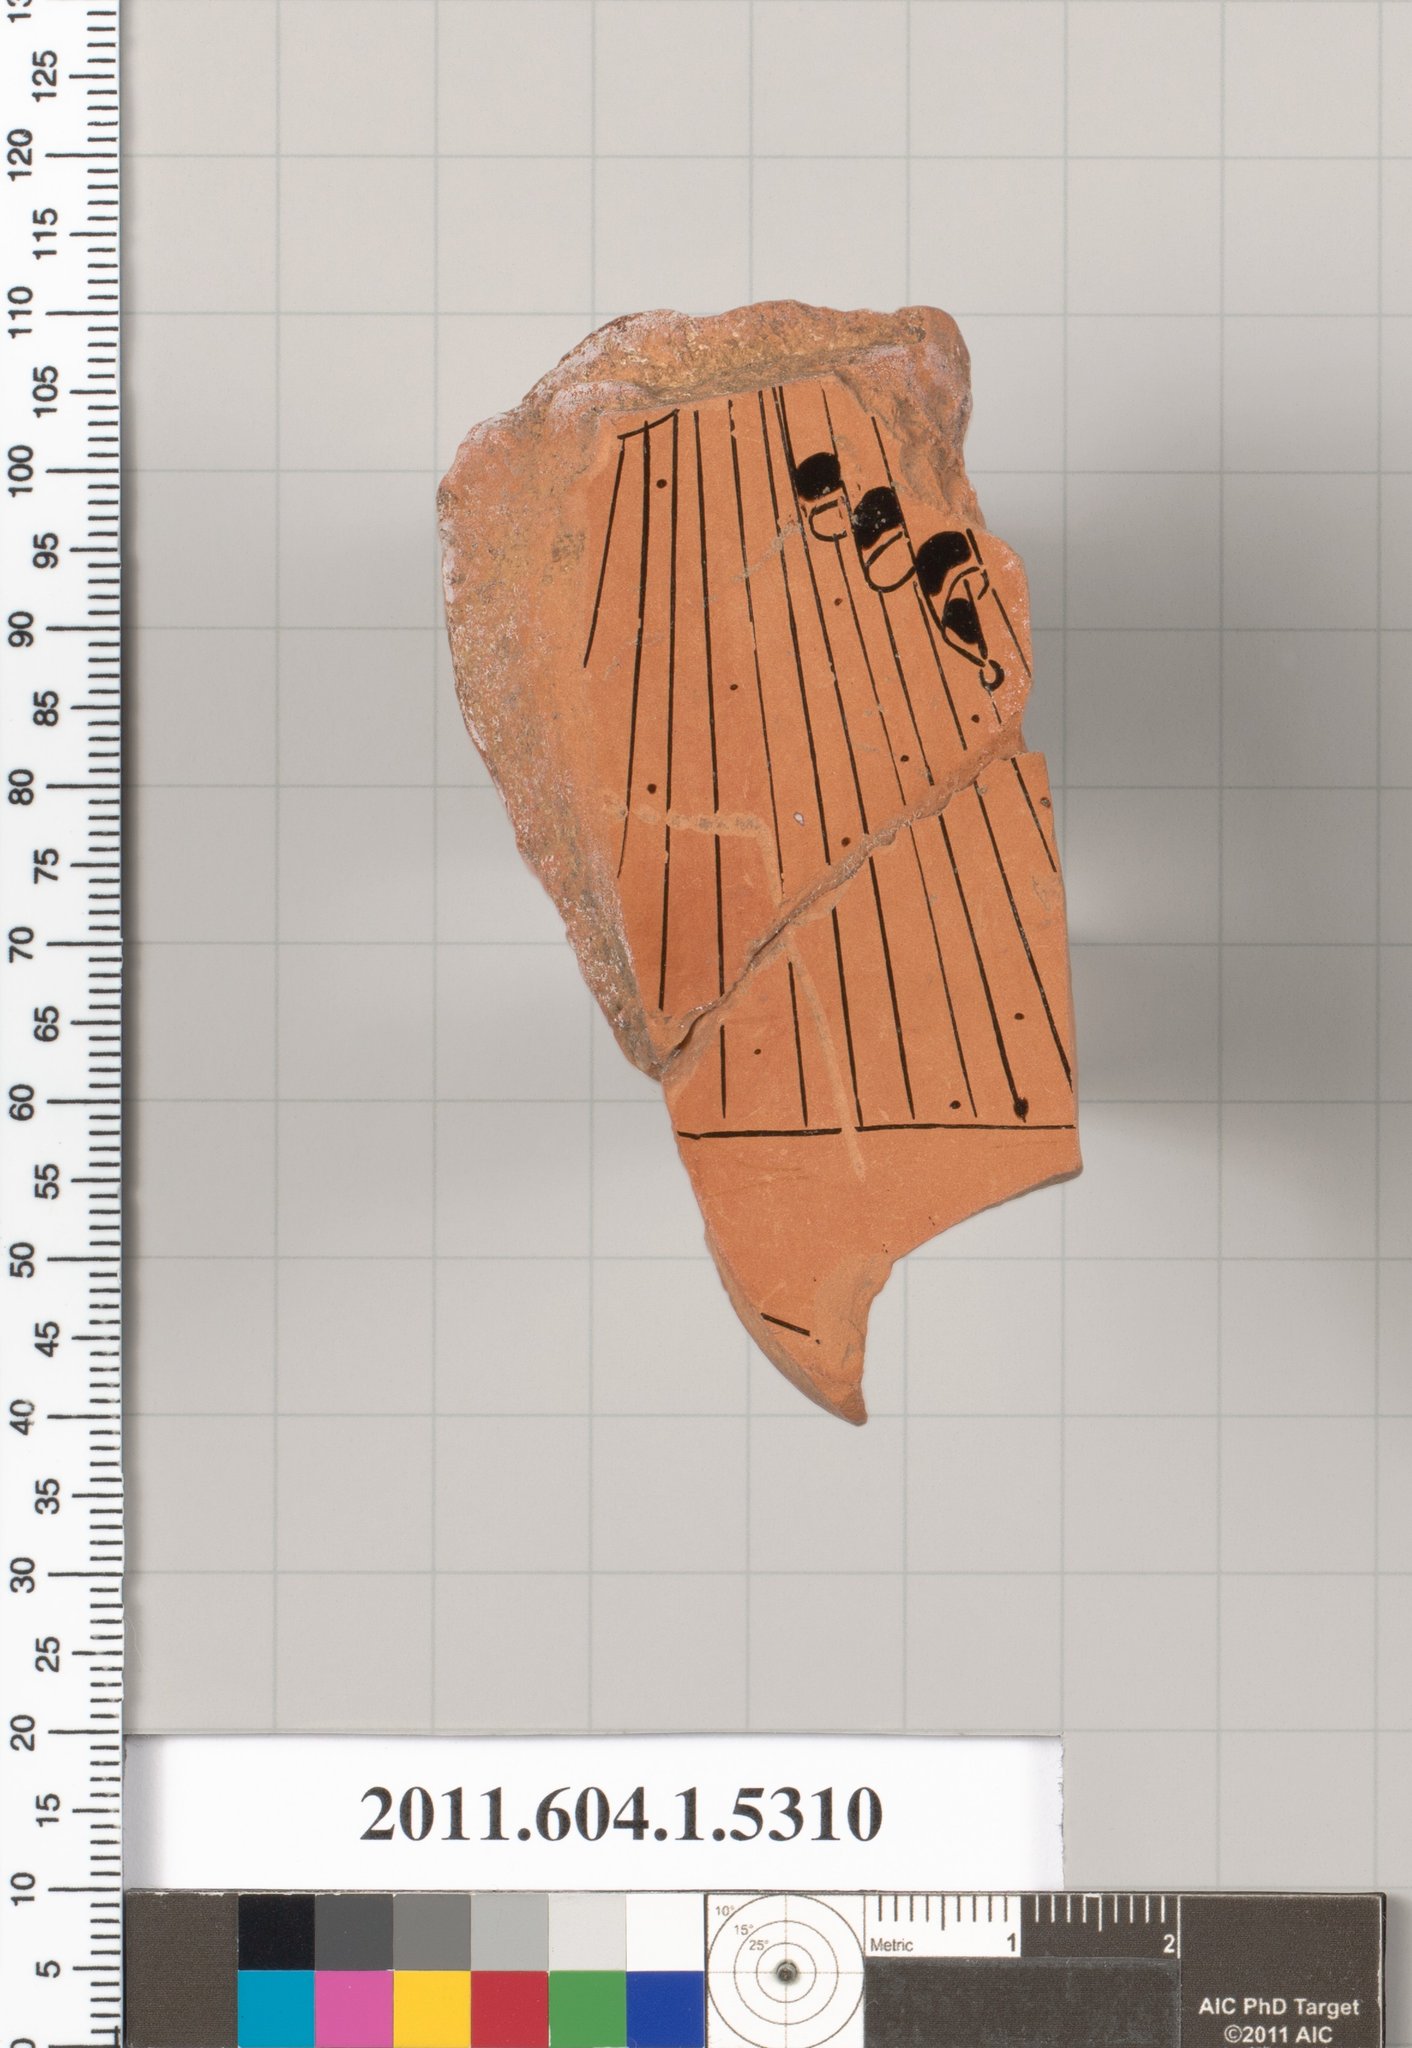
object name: kylix fragment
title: Terracotta fragment of a kylix (drinking cup)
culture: greek, attic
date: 490-470 BCE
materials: terracotta